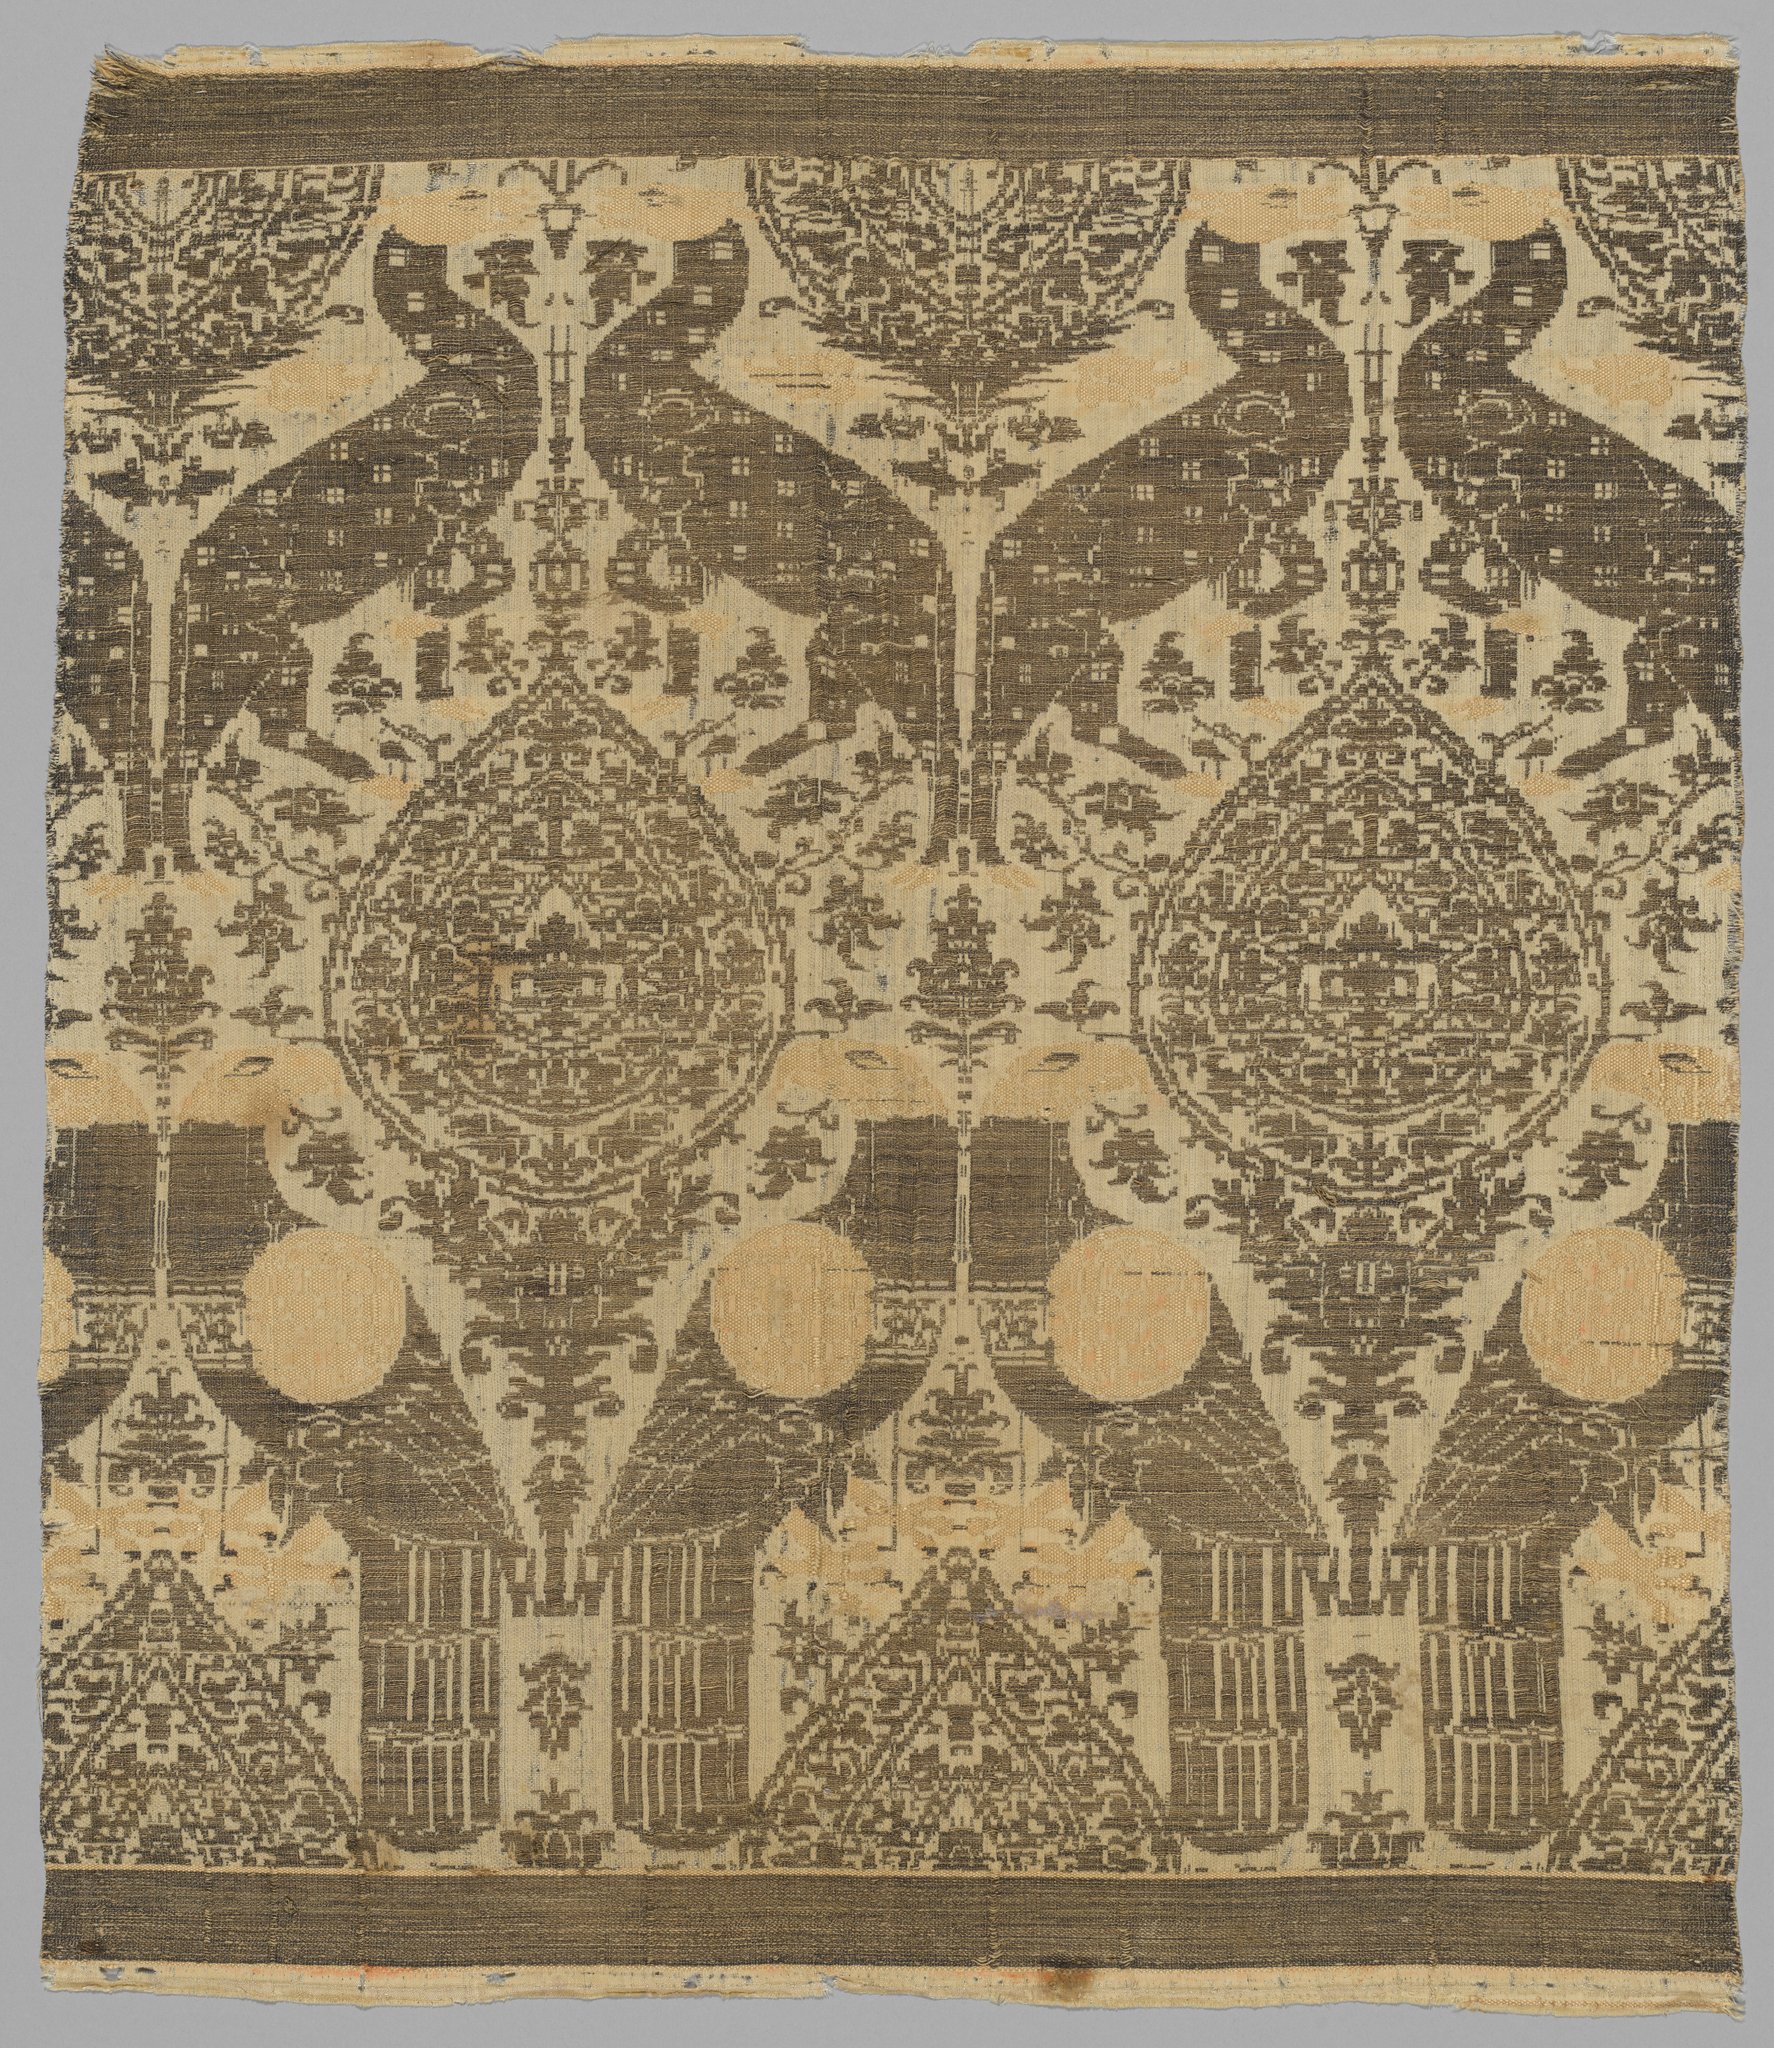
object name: textile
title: Textile with Animals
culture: italian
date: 1267-1333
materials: gold thread, silk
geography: italy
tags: animals,birds